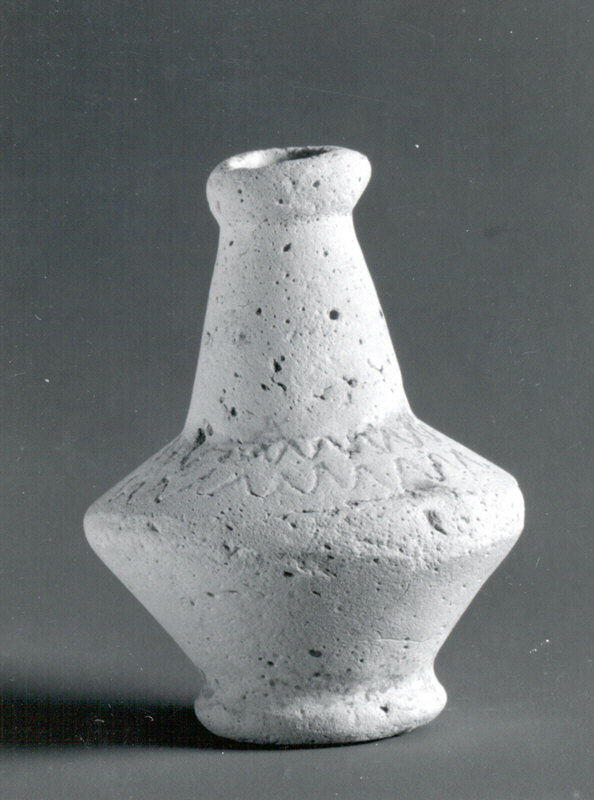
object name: cosmetic container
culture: bactria-margiana archaeological complex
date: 2333-1668 BCE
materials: faience, glaze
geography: bactria-margiana